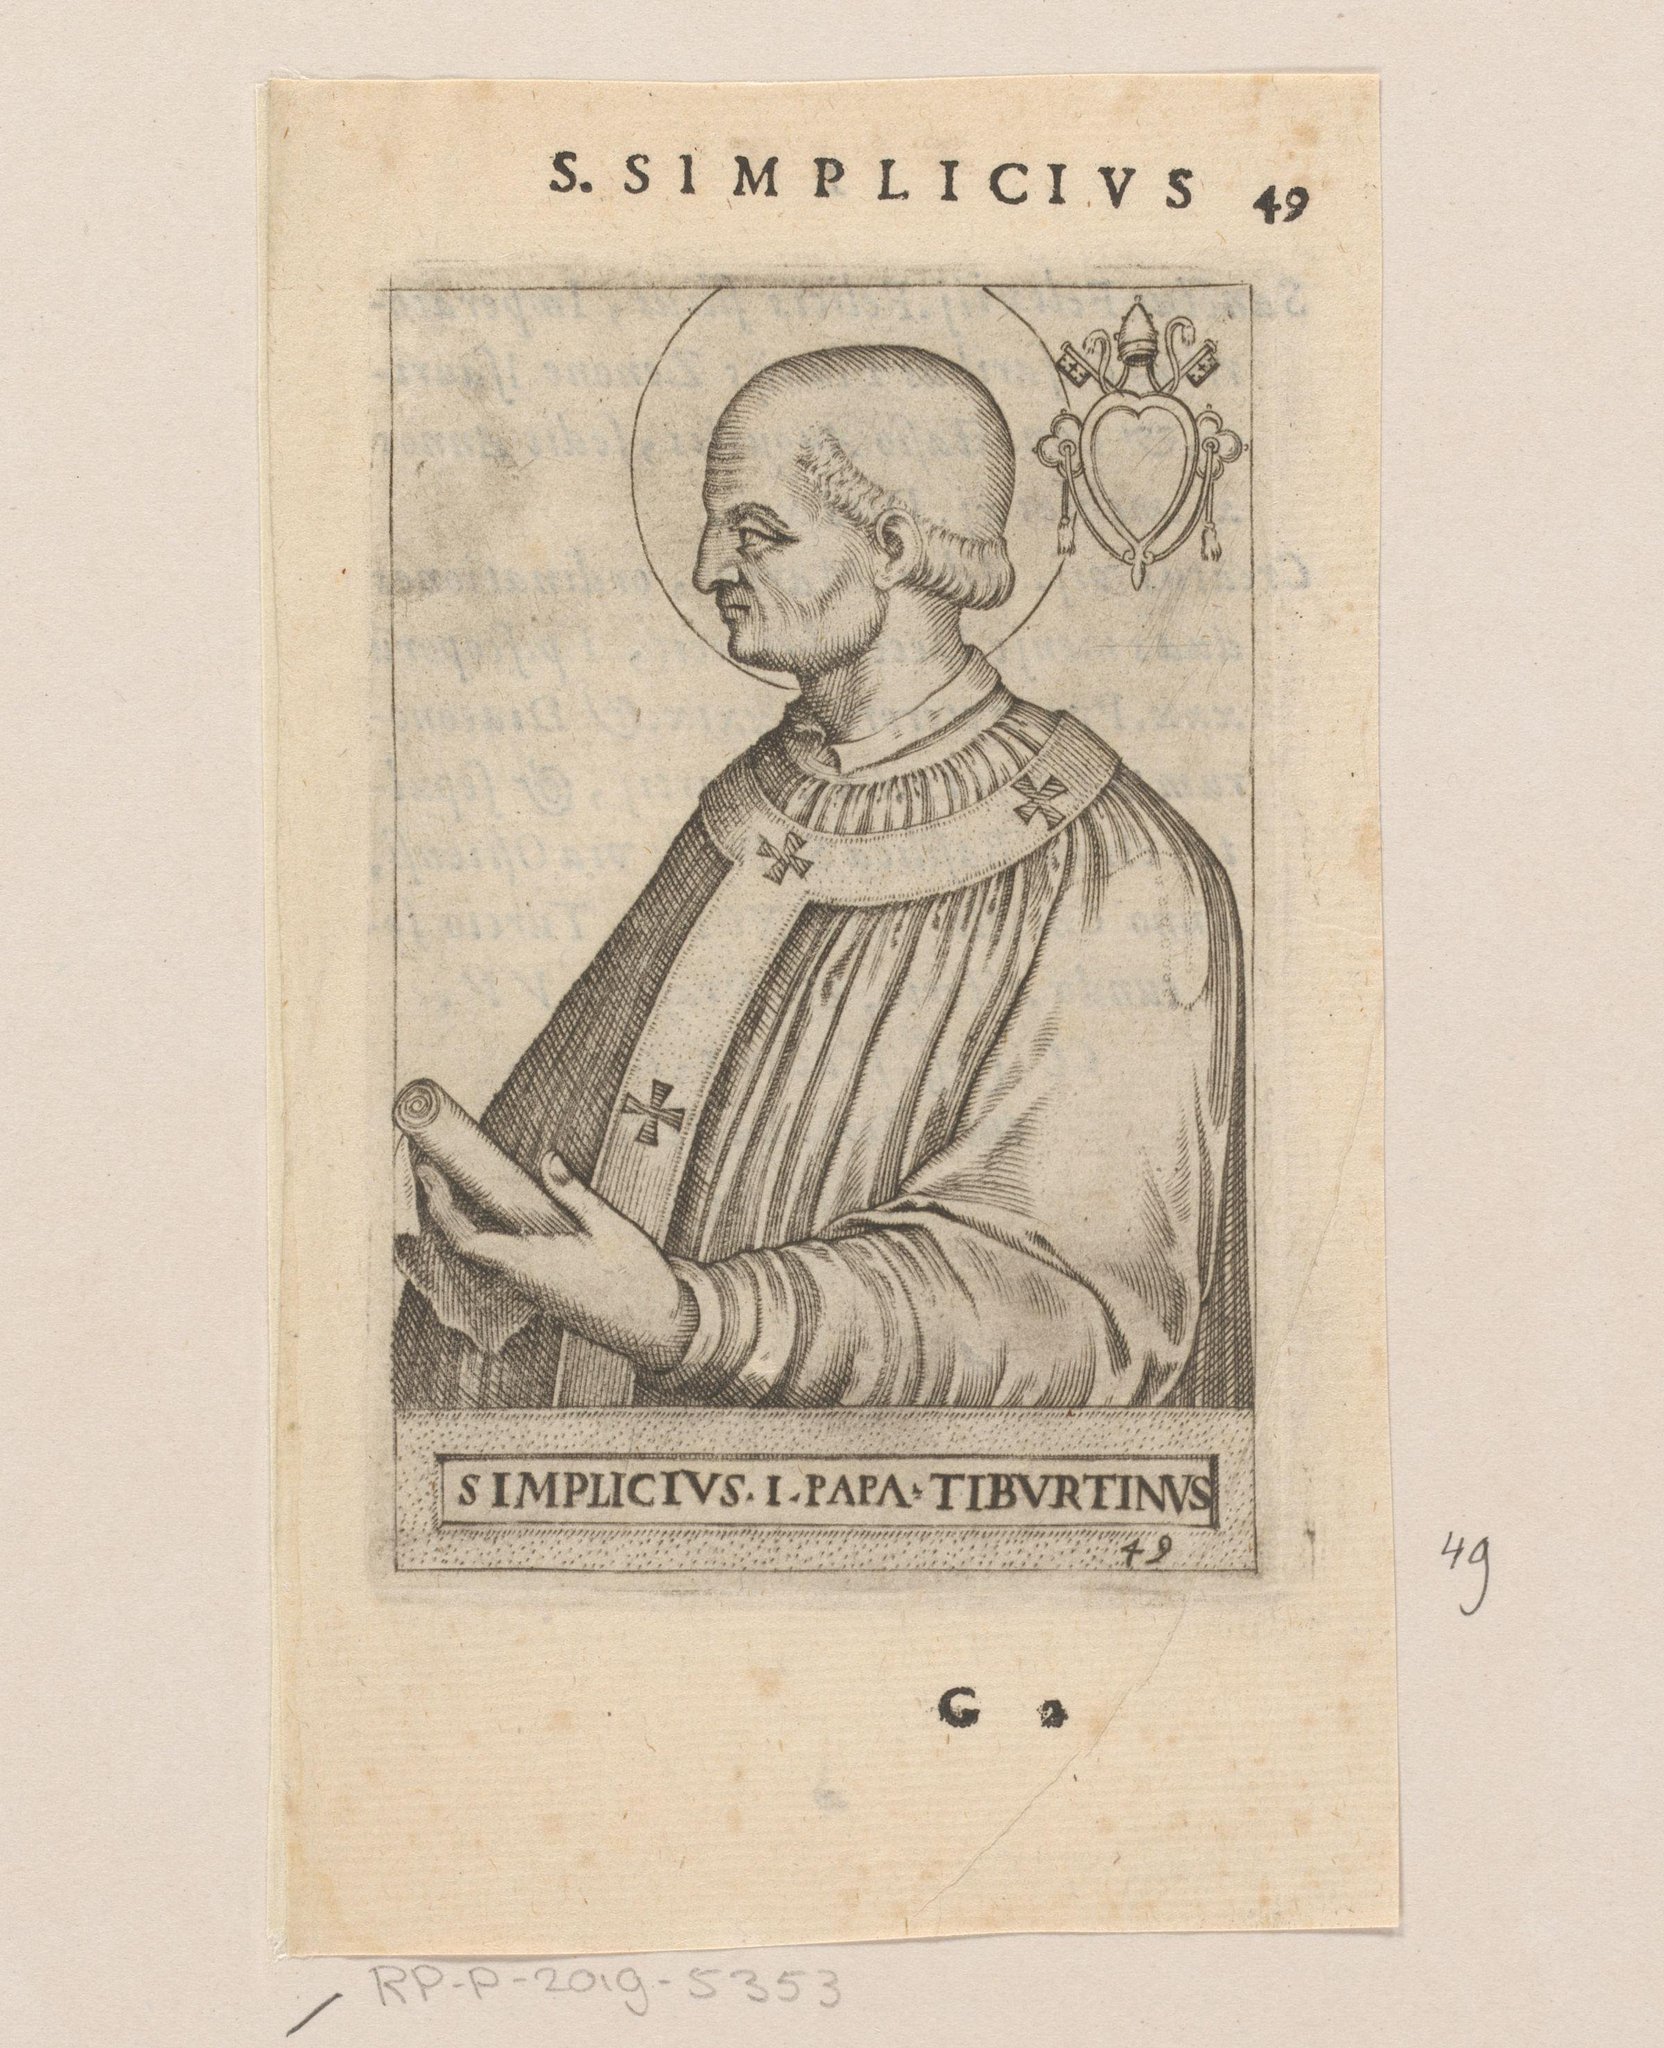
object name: print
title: Simplicius I Papa Tiburtinus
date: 1595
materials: paper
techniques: engraving, letterpress printing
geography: rome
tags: tivoli, historical persons, pope, armorial bearing, heraldry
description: Prent uit: Cavalieri, Giovanni Battista de'. Effigies pontificum romanorum cum eorum vitis (...). Rome: Bartolomeo Bonfadino, 1595. Prent voor het eerst verschenen in: Cavalieri, Giovanni Battista de'. Pontificum romanorum effigies (...). Rome: Domenico Basa en Francesco Zanetti, 1580. Prent ook gebruikt in latere publicaties.